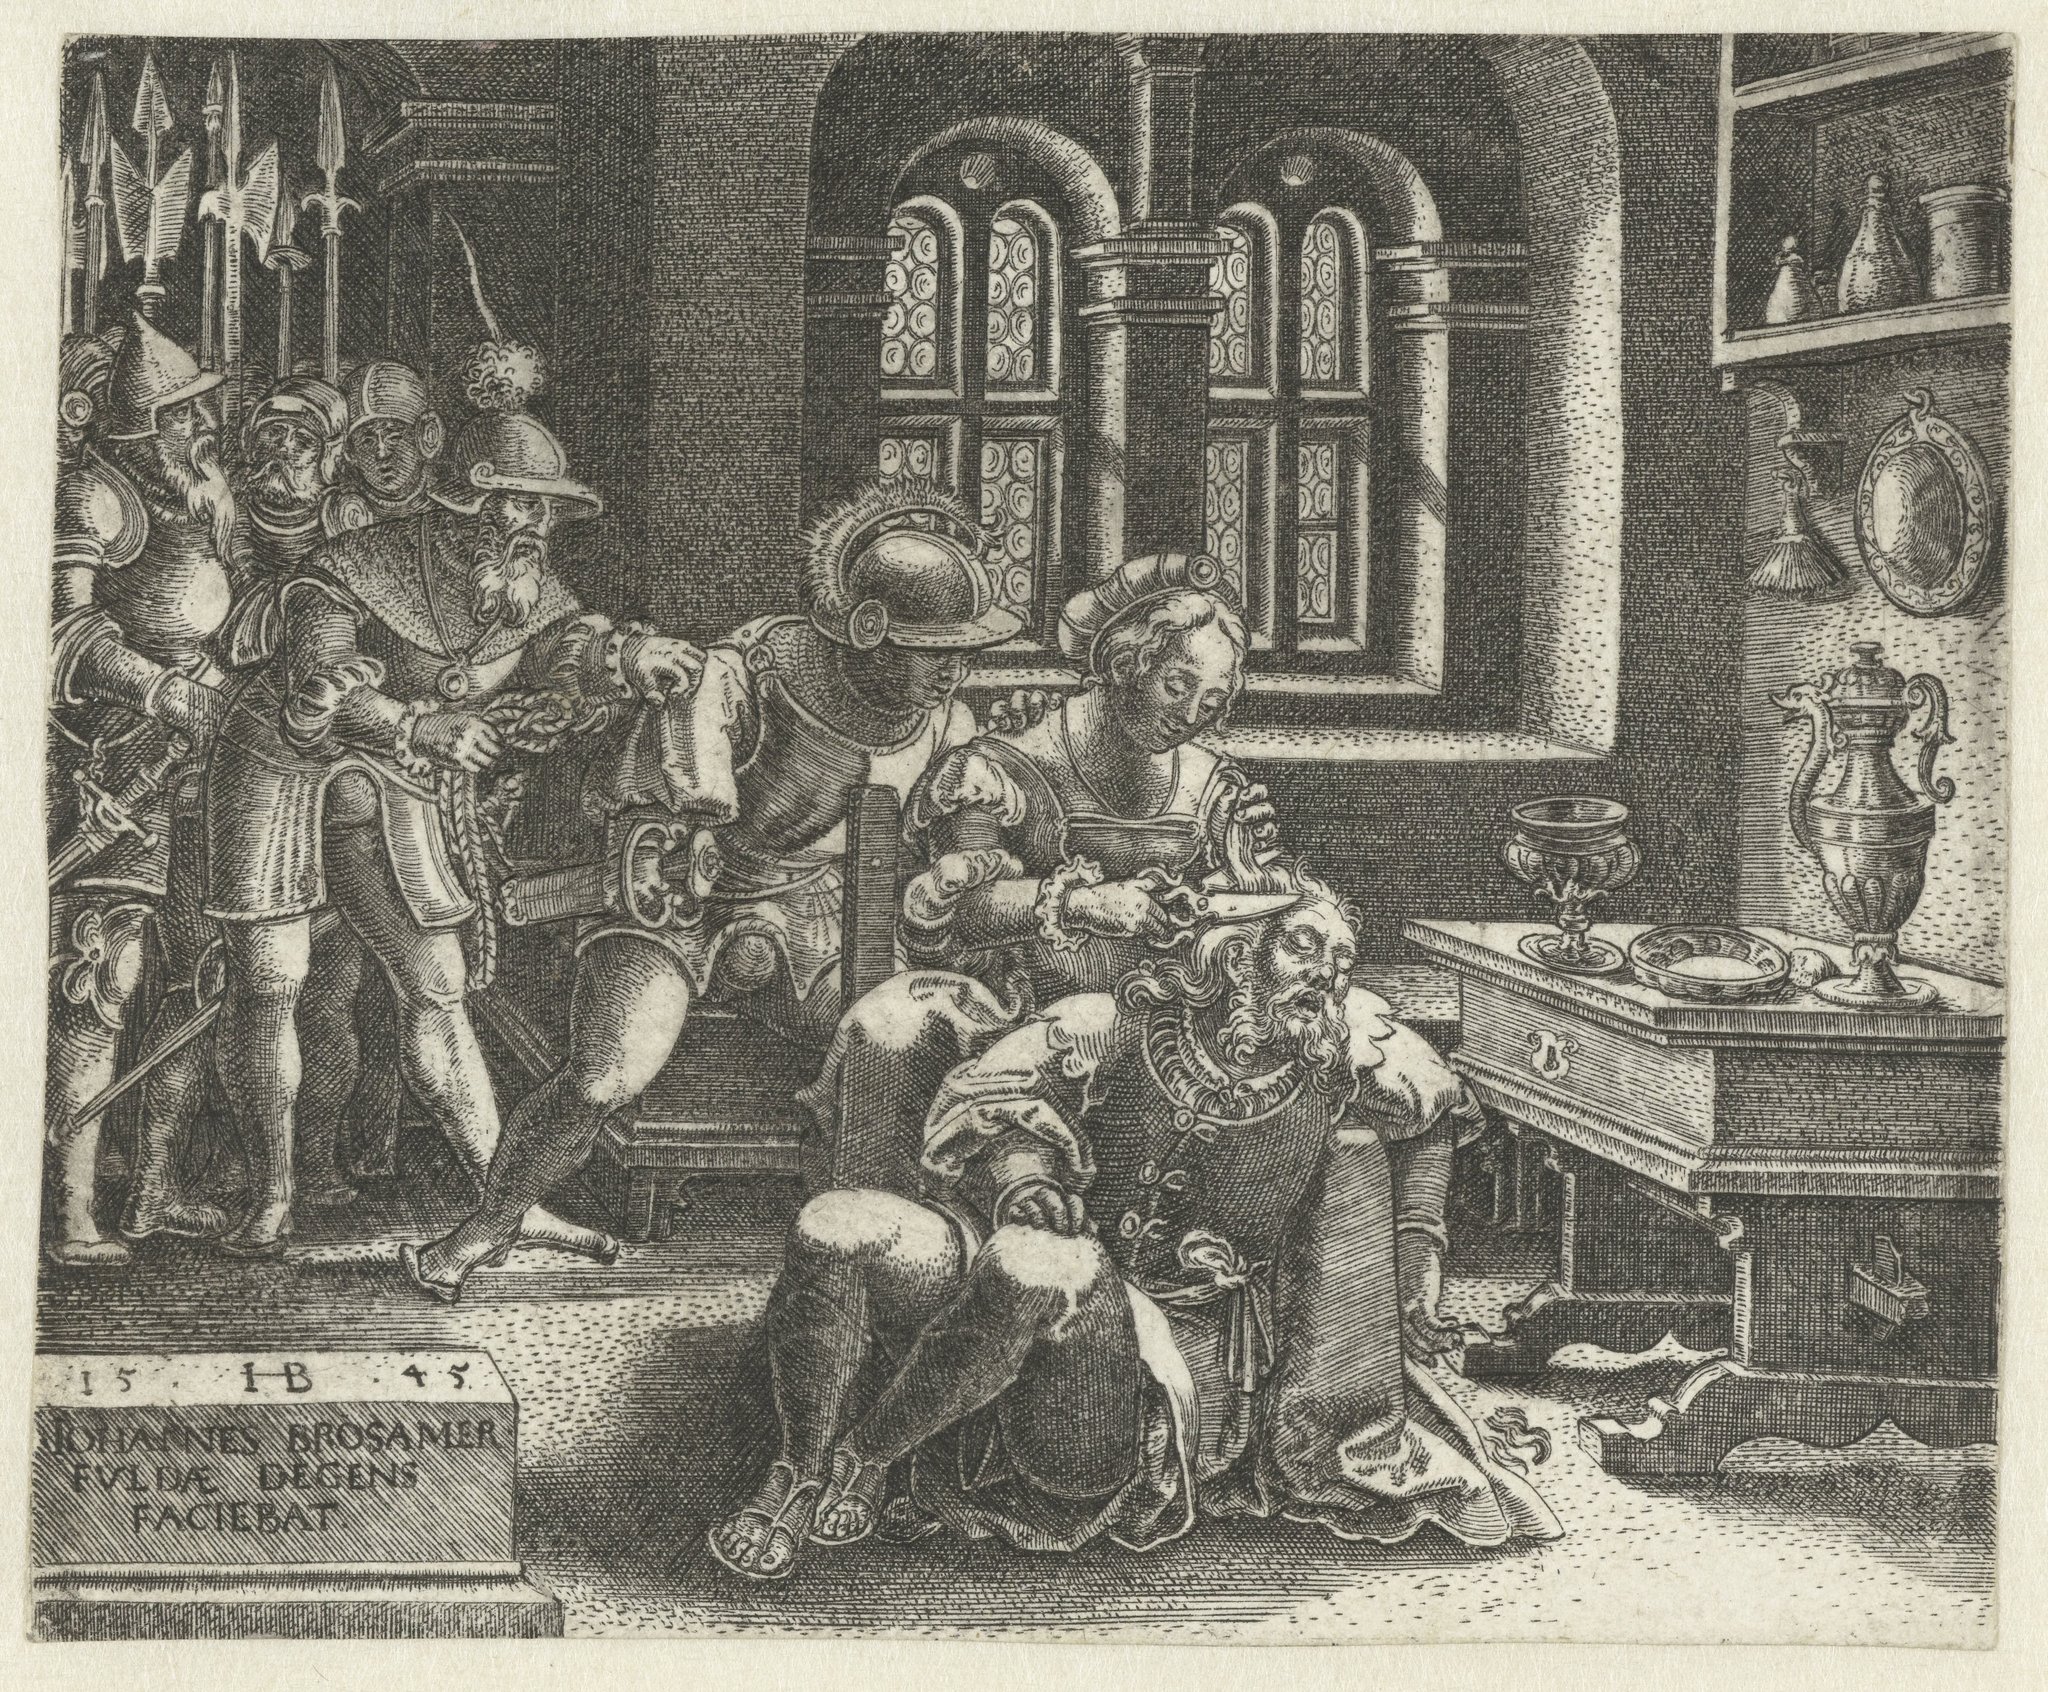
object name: print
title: Delila knipt het haar van slapende Simson (Samson) terwijl Filistijnen wachten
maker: hans brosamer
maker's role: print maker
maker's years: 1500-1554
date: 1545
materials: paper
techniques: engraving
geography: fulda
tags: samson asleep in delilah's lap; she is usually shown beckoning to a philistine or putting a finger to her lips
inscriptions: collector's mark: Lugt 2228a, collector's mark: Lugt 2669